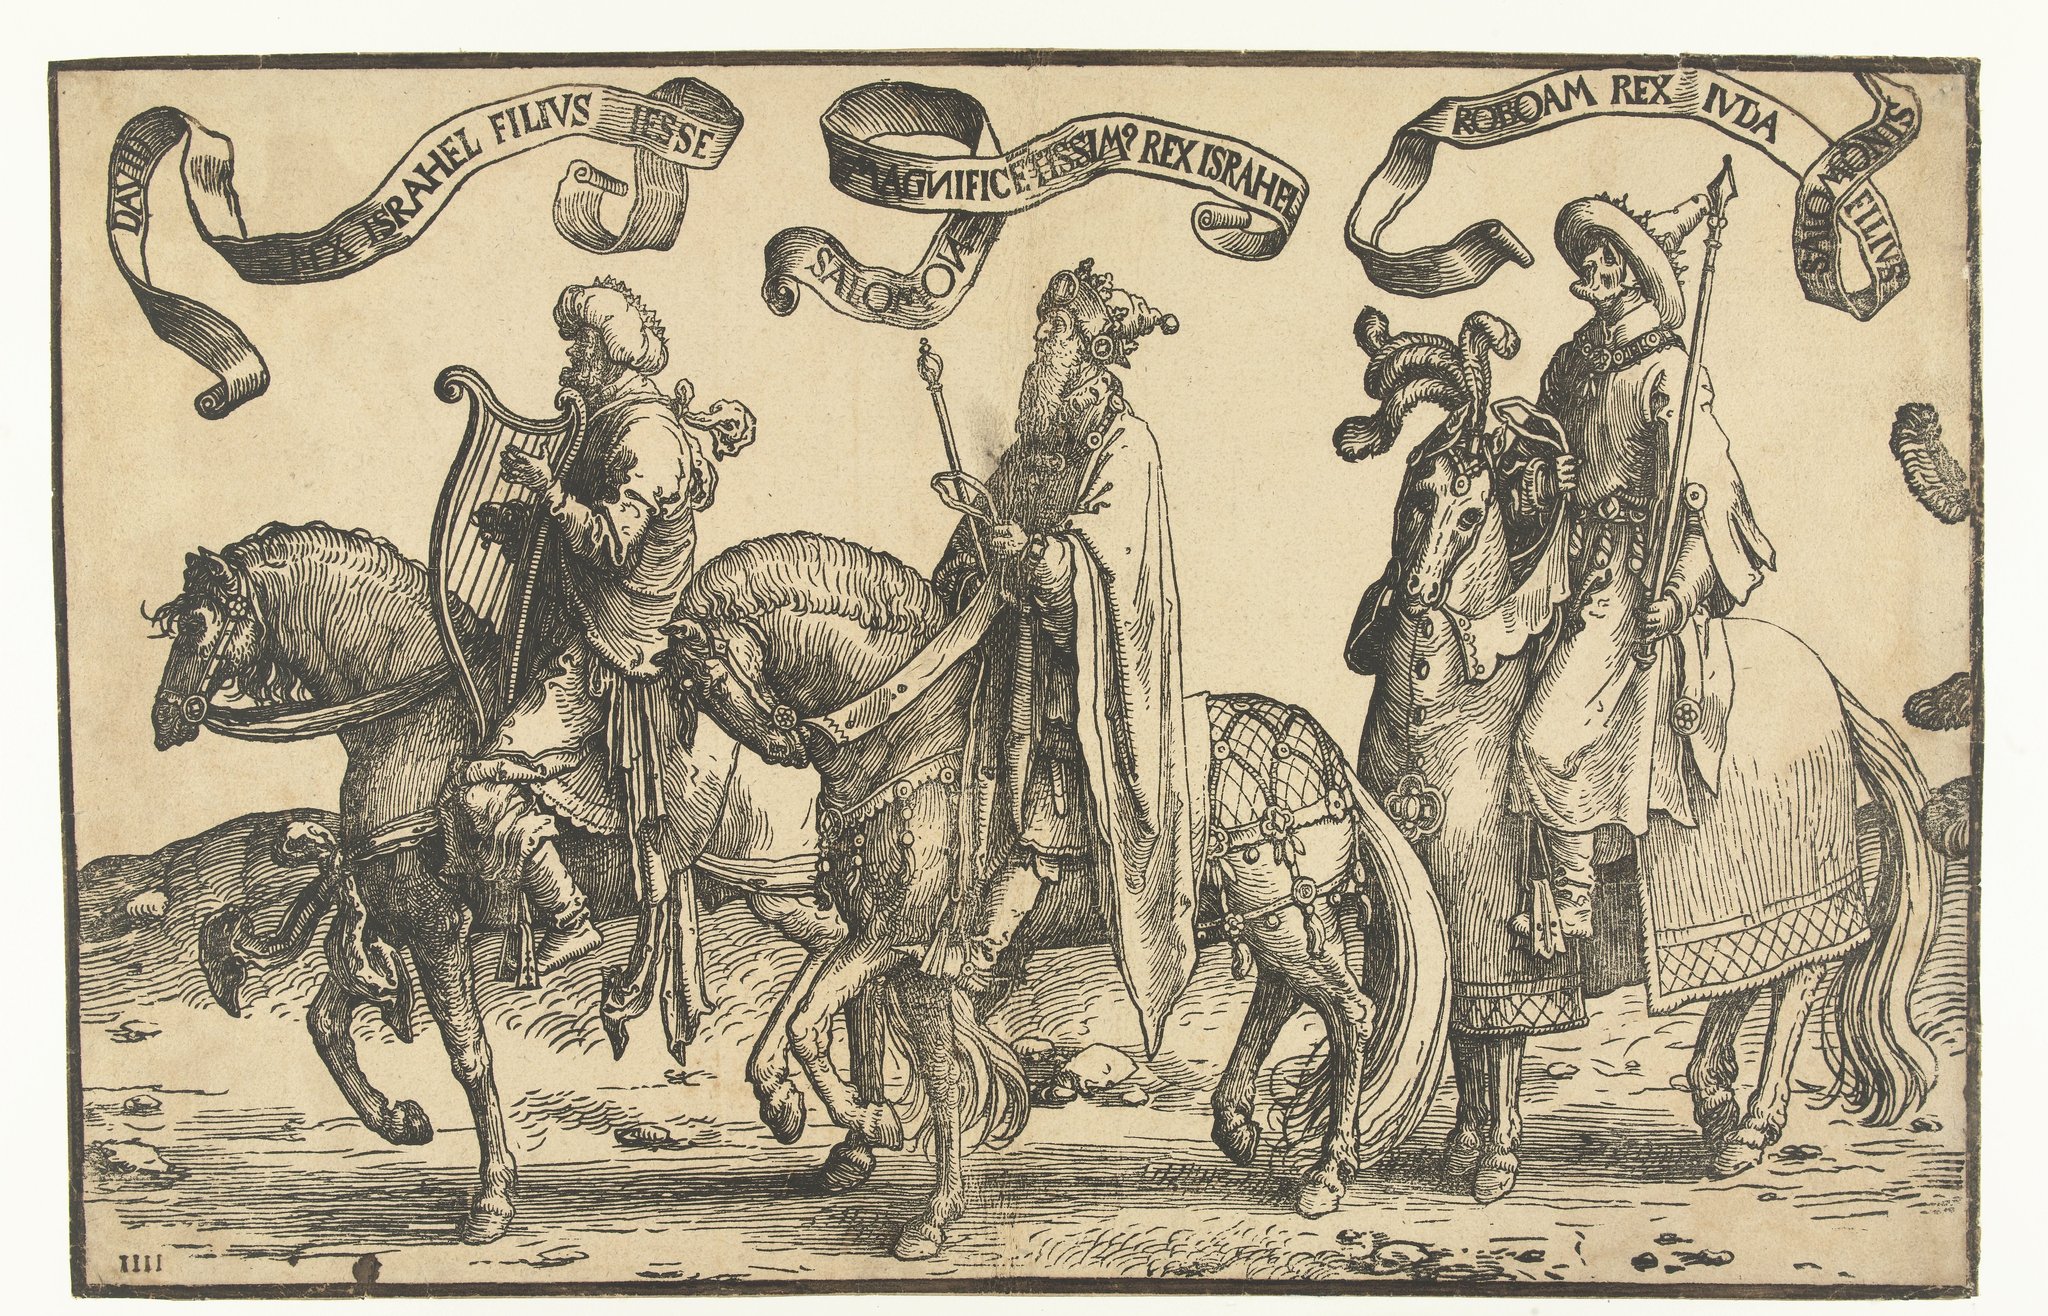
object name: print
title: Koningen David, Salomo en Jerobeam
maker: lucas van leyden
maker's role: draughtsman, painter, print maker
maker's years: 1494-1533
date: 1518-1522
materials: paper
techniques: brush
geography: low countries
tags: david (not in biblical context); possible attributes: crown, harp, kings of israel and judah ~ the old testament (not in biblical context), male persons from the old testament (with name) (not in biblical context)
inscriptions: collector's mark: Lugt 240, number: ‘3’, number: ‘IIII’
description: Eén van vier houtsneden, onderdeel van fries met koningen van Israël. David met lier te paard, gevolgd door Salomo en Jerobeam te paard. Boven alle drie banderol met naam en toenaam.